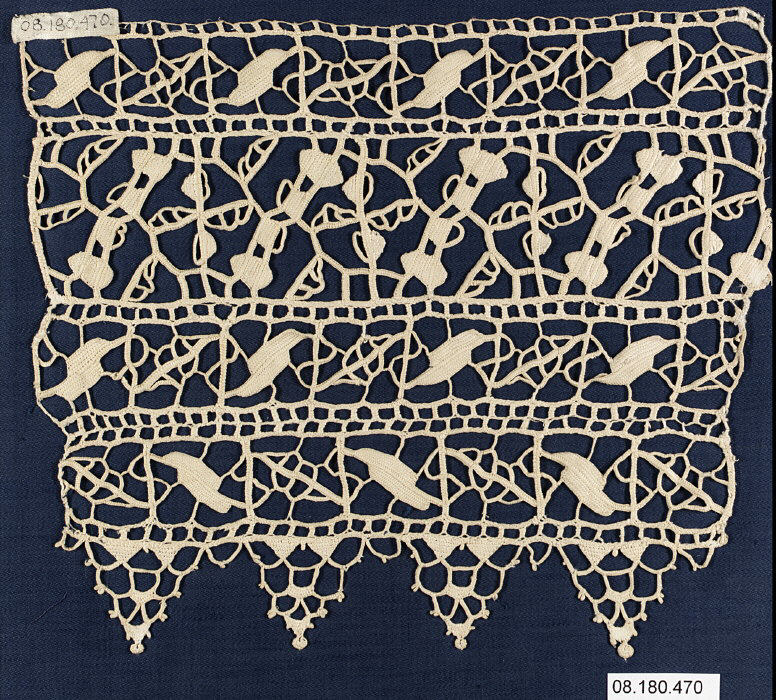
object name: fragment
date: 1601-1700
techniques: lace